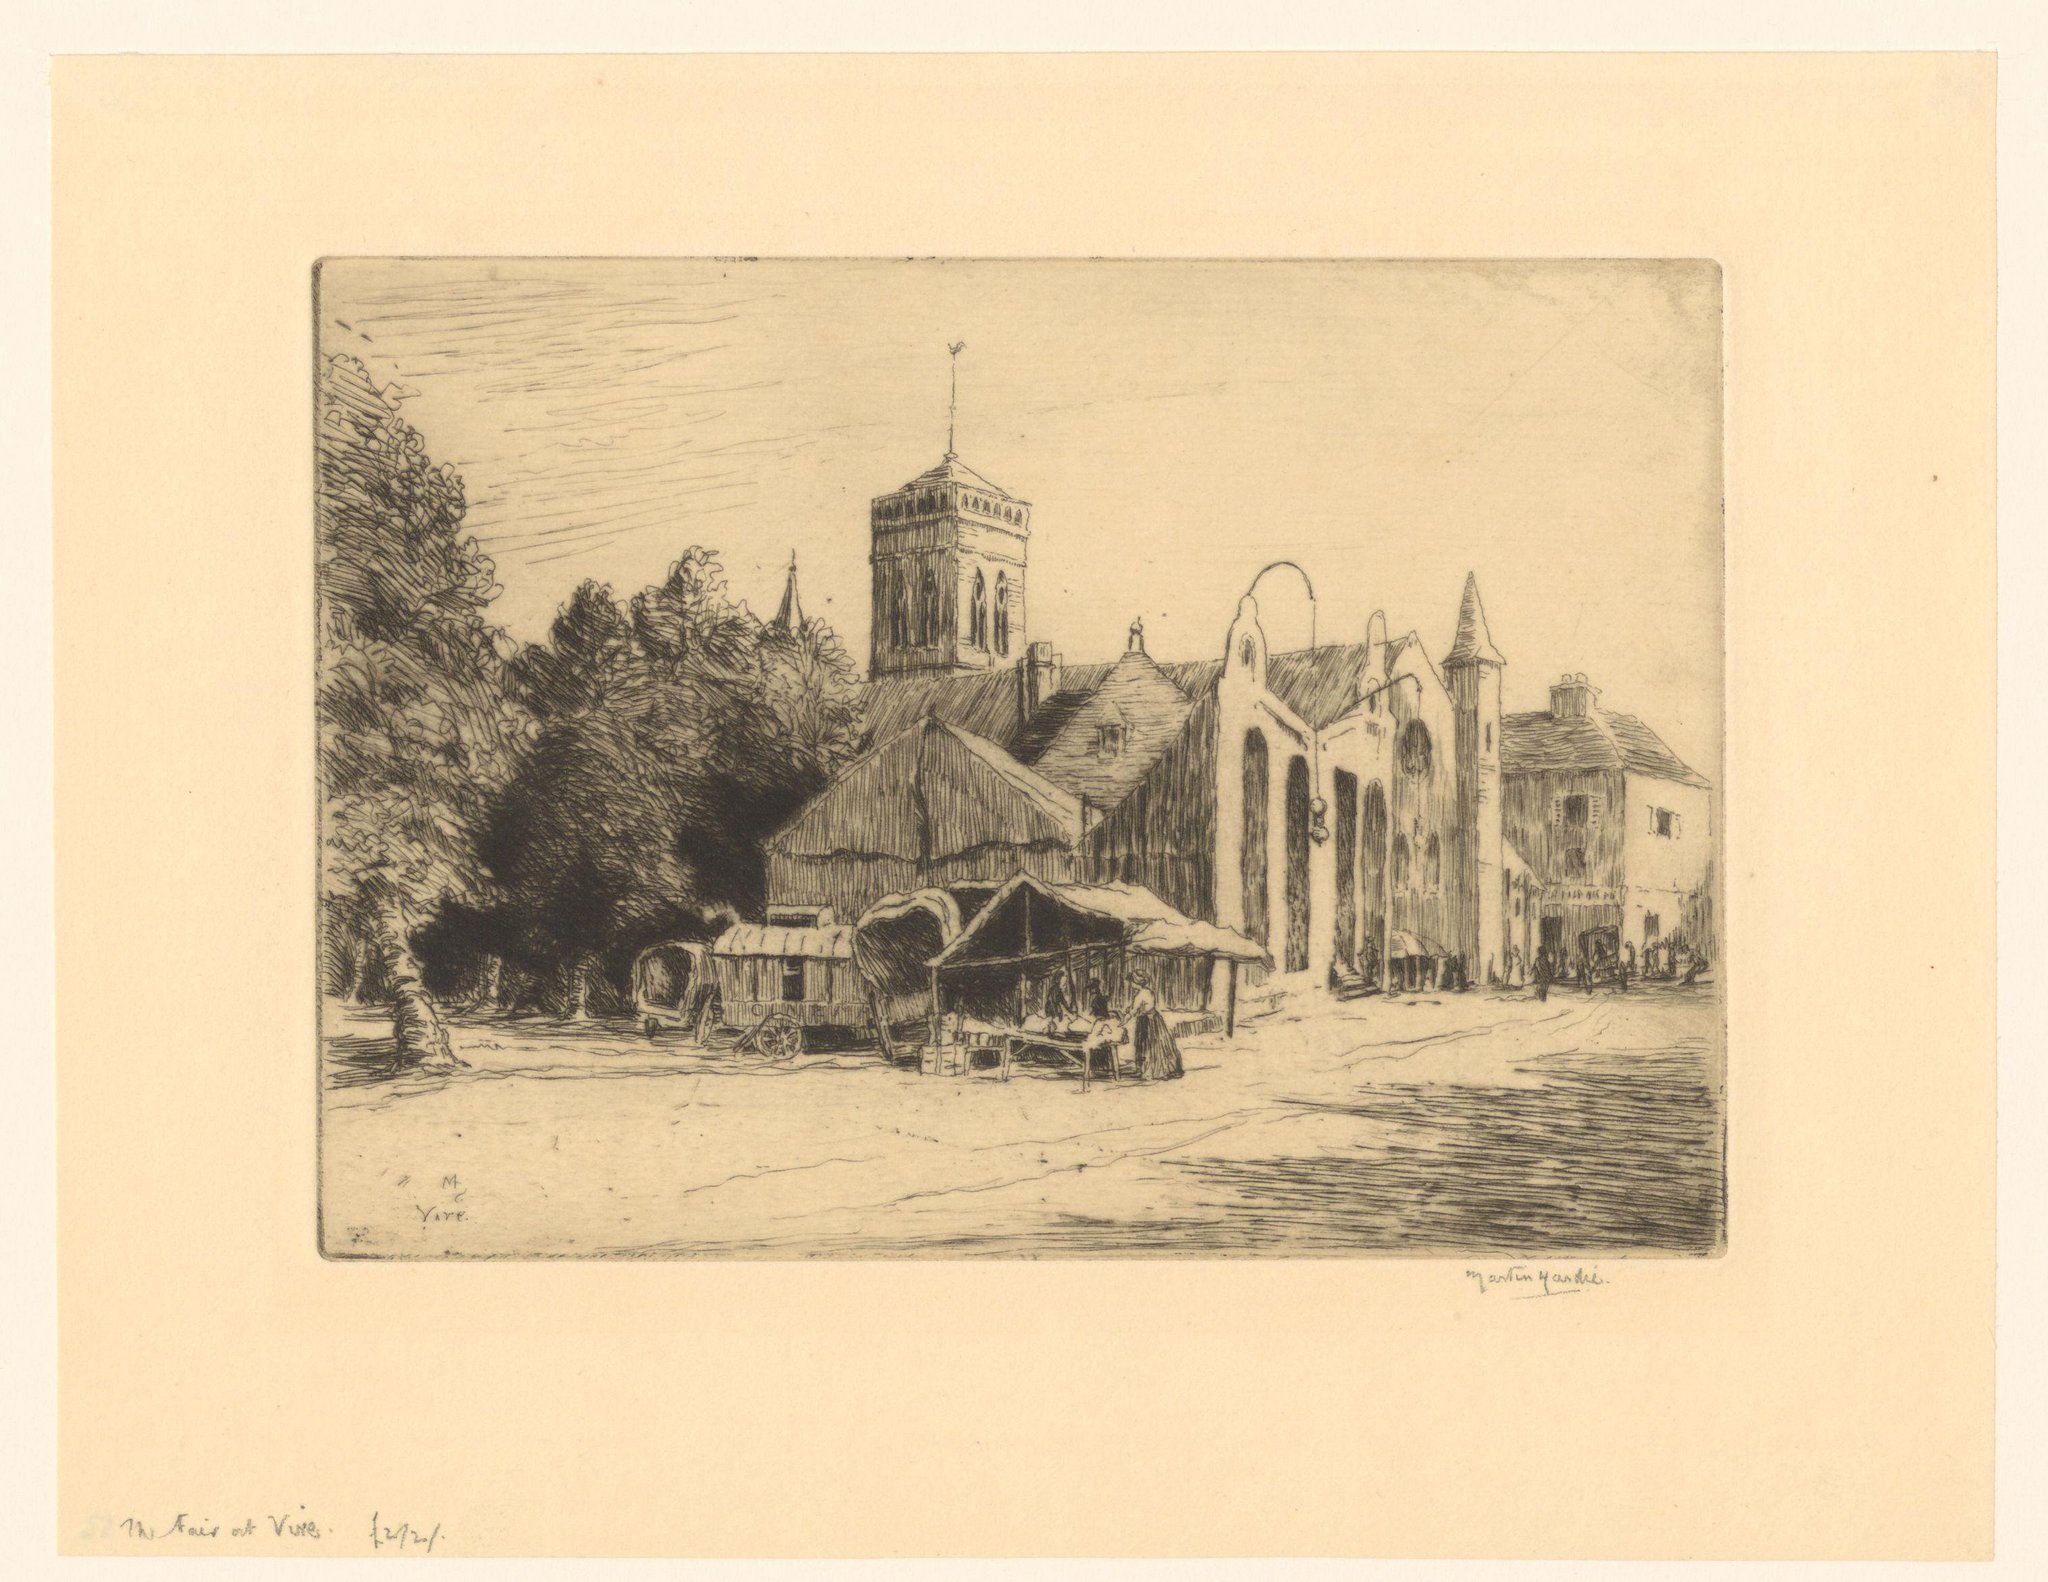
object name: print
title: Vire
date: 1913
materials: paper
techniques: etching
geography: vire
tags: city-view in general; 'veduta', market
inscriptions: annotation: ‘Martin Hardie’, collector's mark: Lugt 2760, collector's mark: Lugt 2228